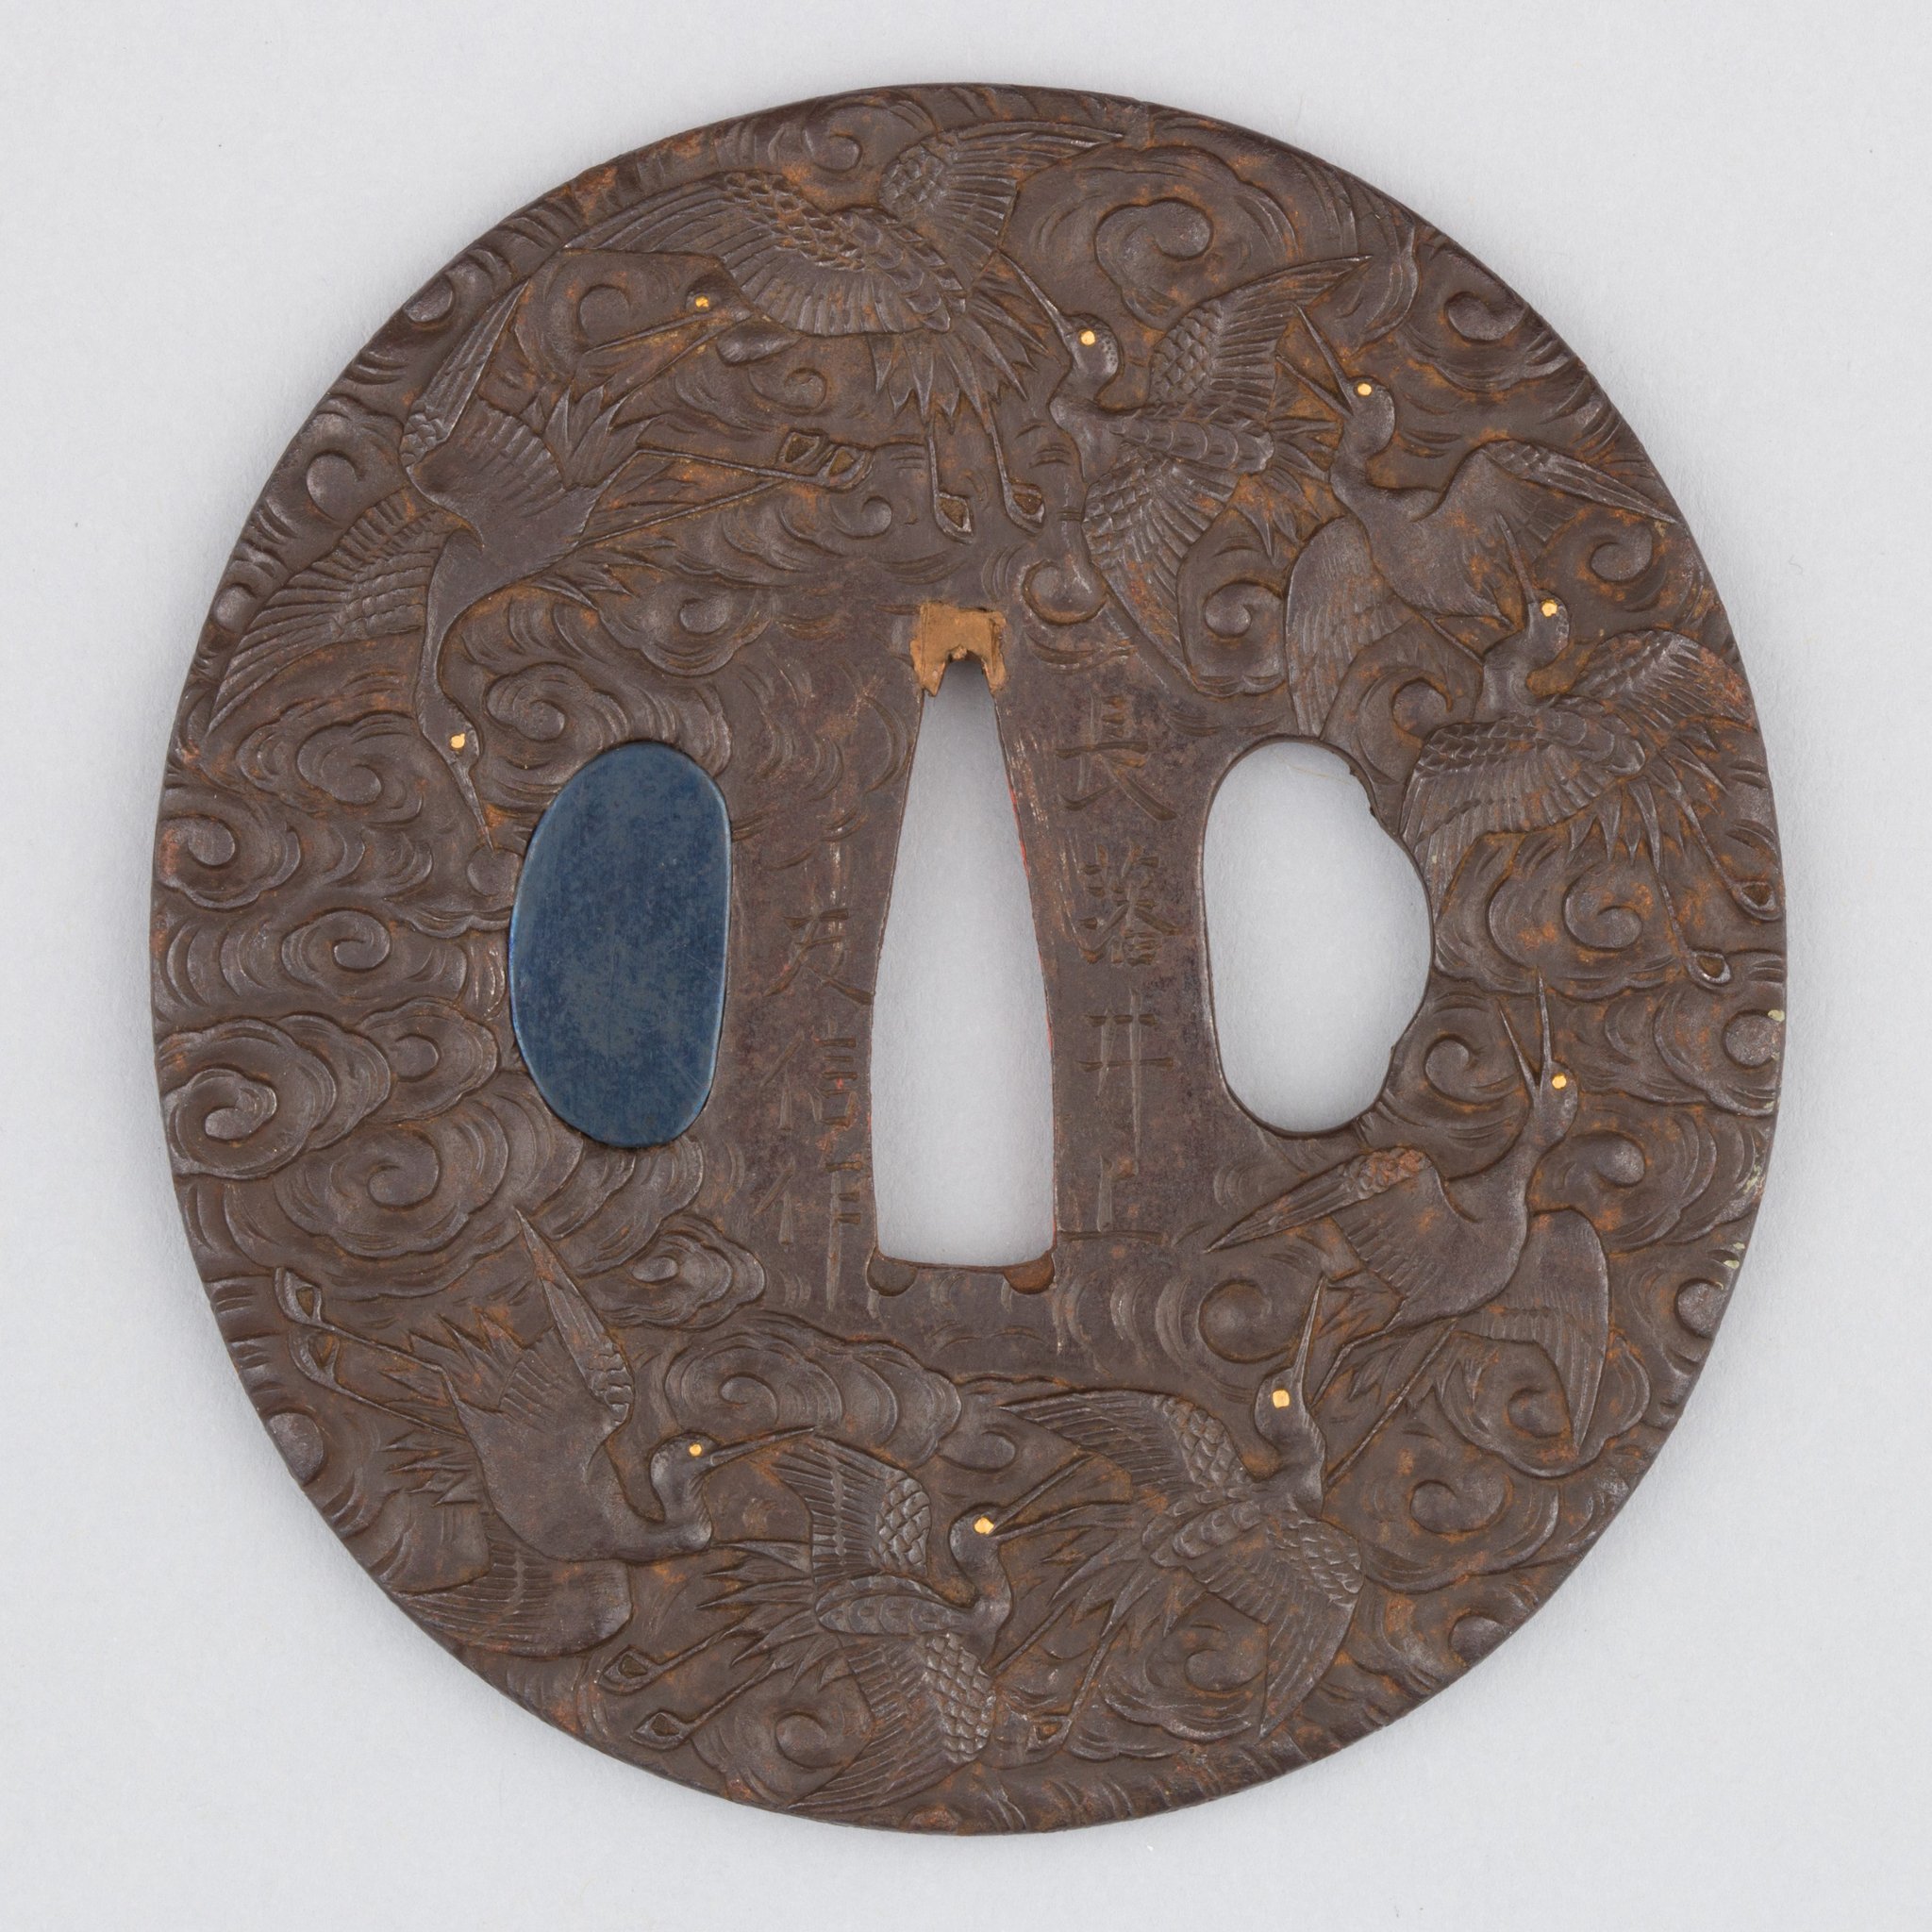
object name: sword guard tsuba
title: Sword Guard (Tsuba)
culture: japanese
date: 1615-1868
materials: copper, gold, iron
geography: japan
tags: birds